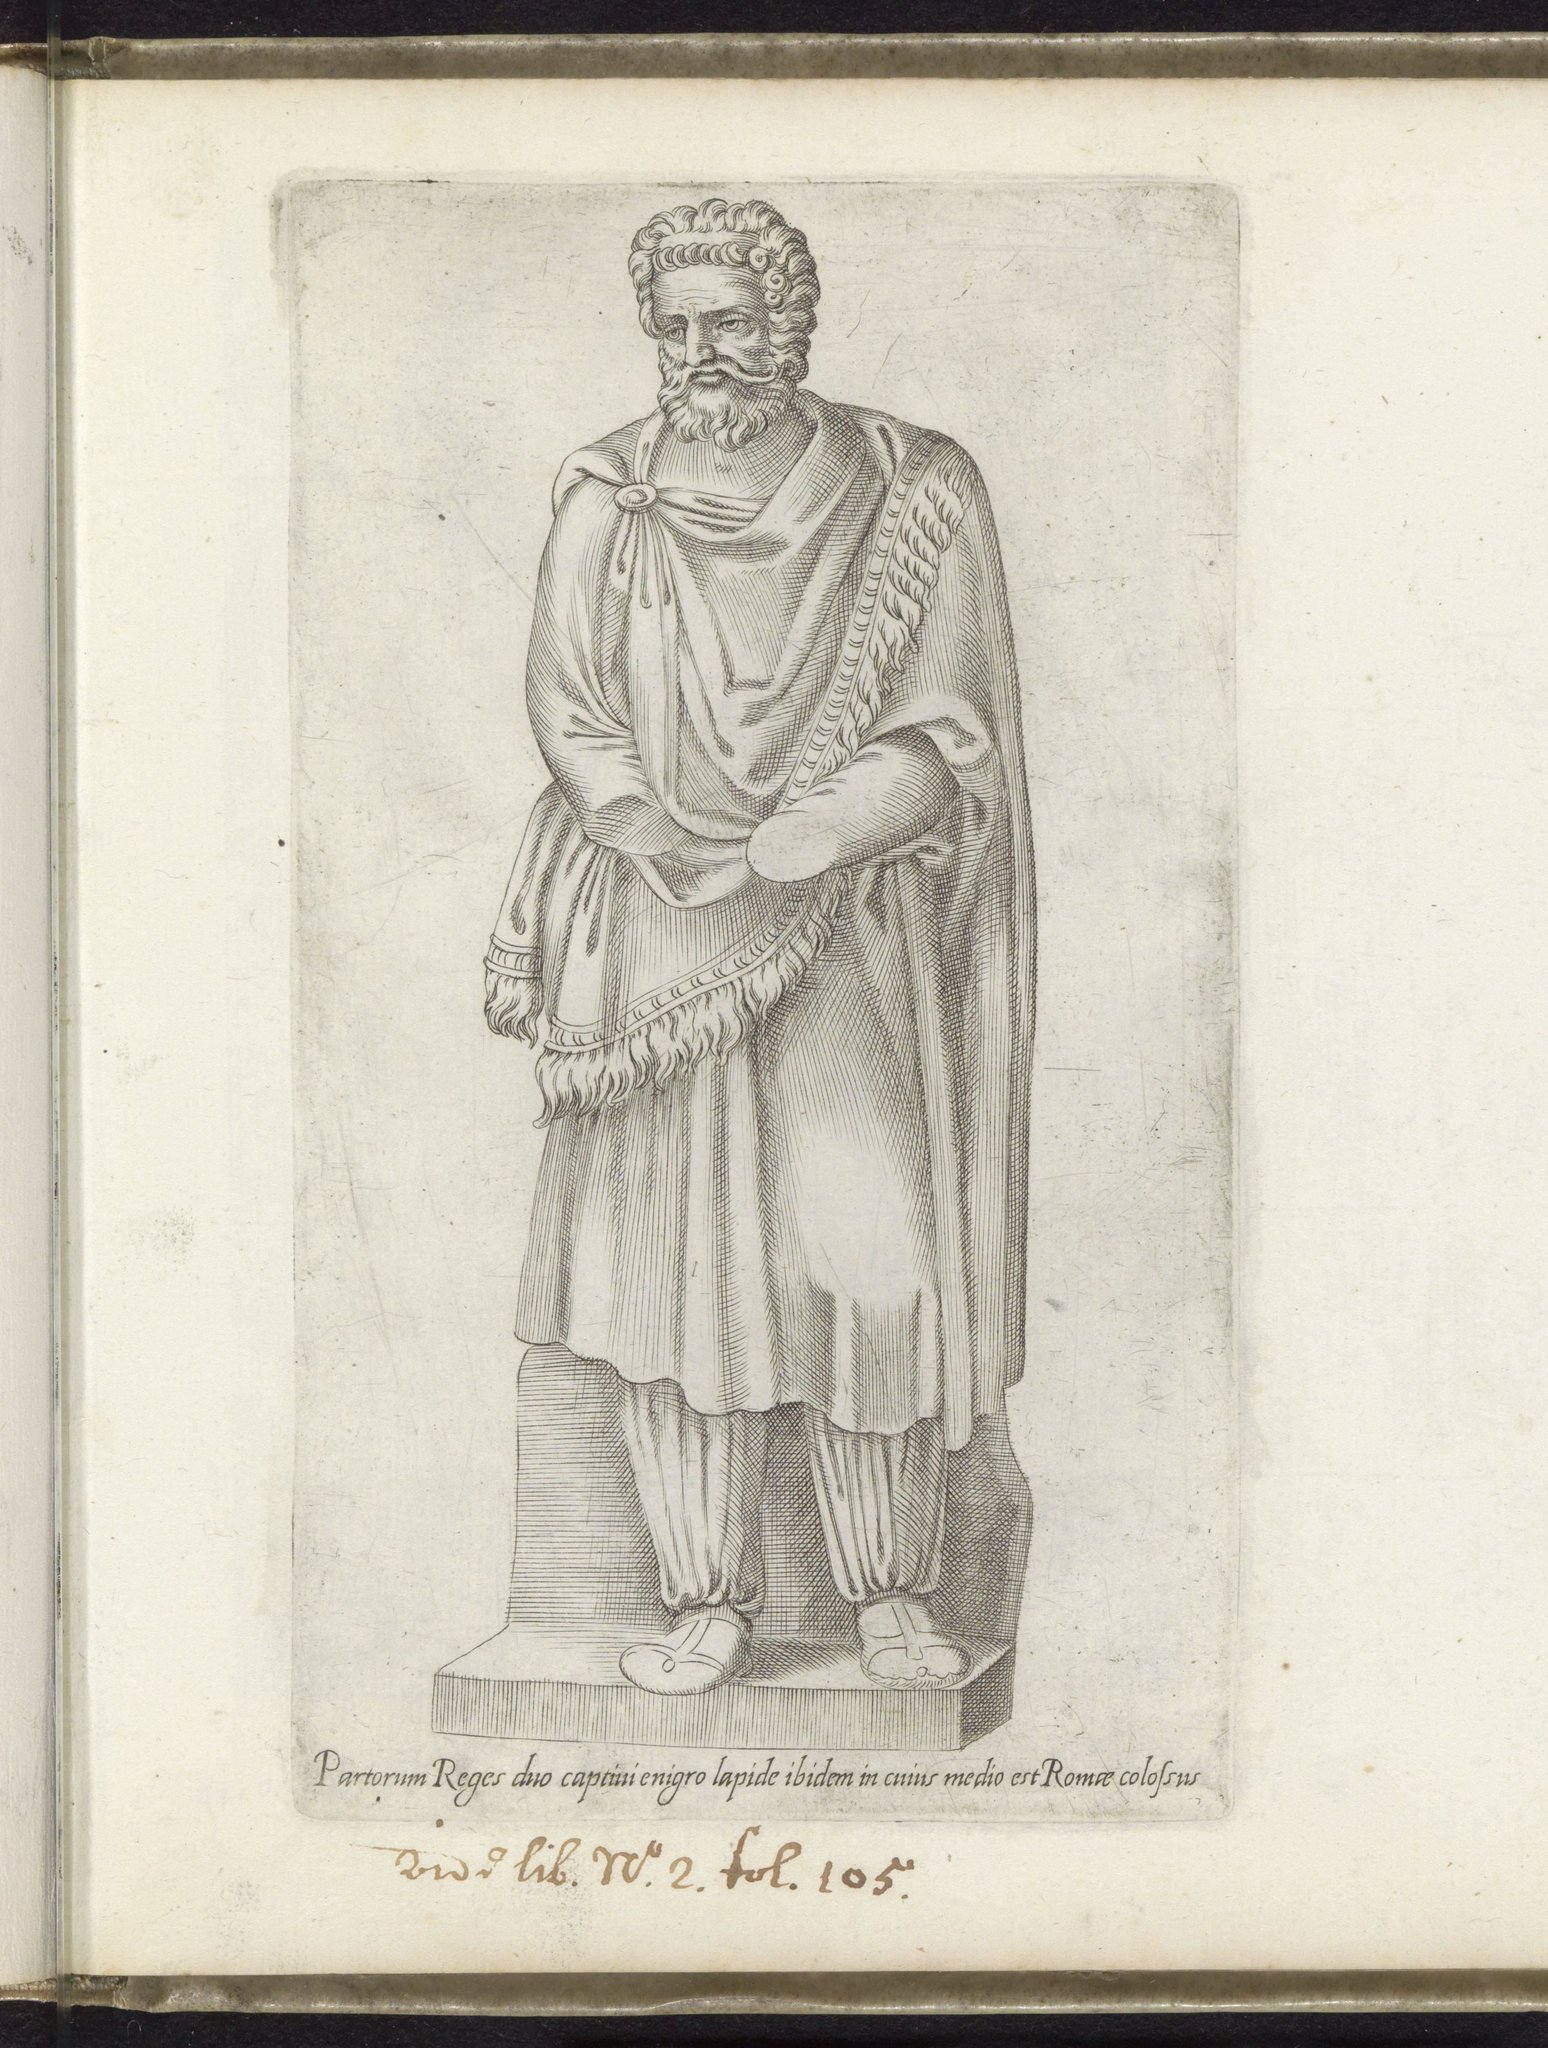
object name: print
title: Sculptuur van een barbaarse gevangene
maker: Anonymous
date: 1600-1699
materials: paper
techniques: engraving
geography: italy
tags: piece of sculpture, reproduction of a piece of sculpture, prisoner of war (after the battle)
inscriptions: inscription: ‘Ende lib. No. 2. fol. 105.’, inscription: ‘Ende lib. No. 2. fol. 105.’, number: ‘90’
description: Deze prent maakt deel uit van een reeks van ten minste 50 prenten van sculpturen uit de oudheid.